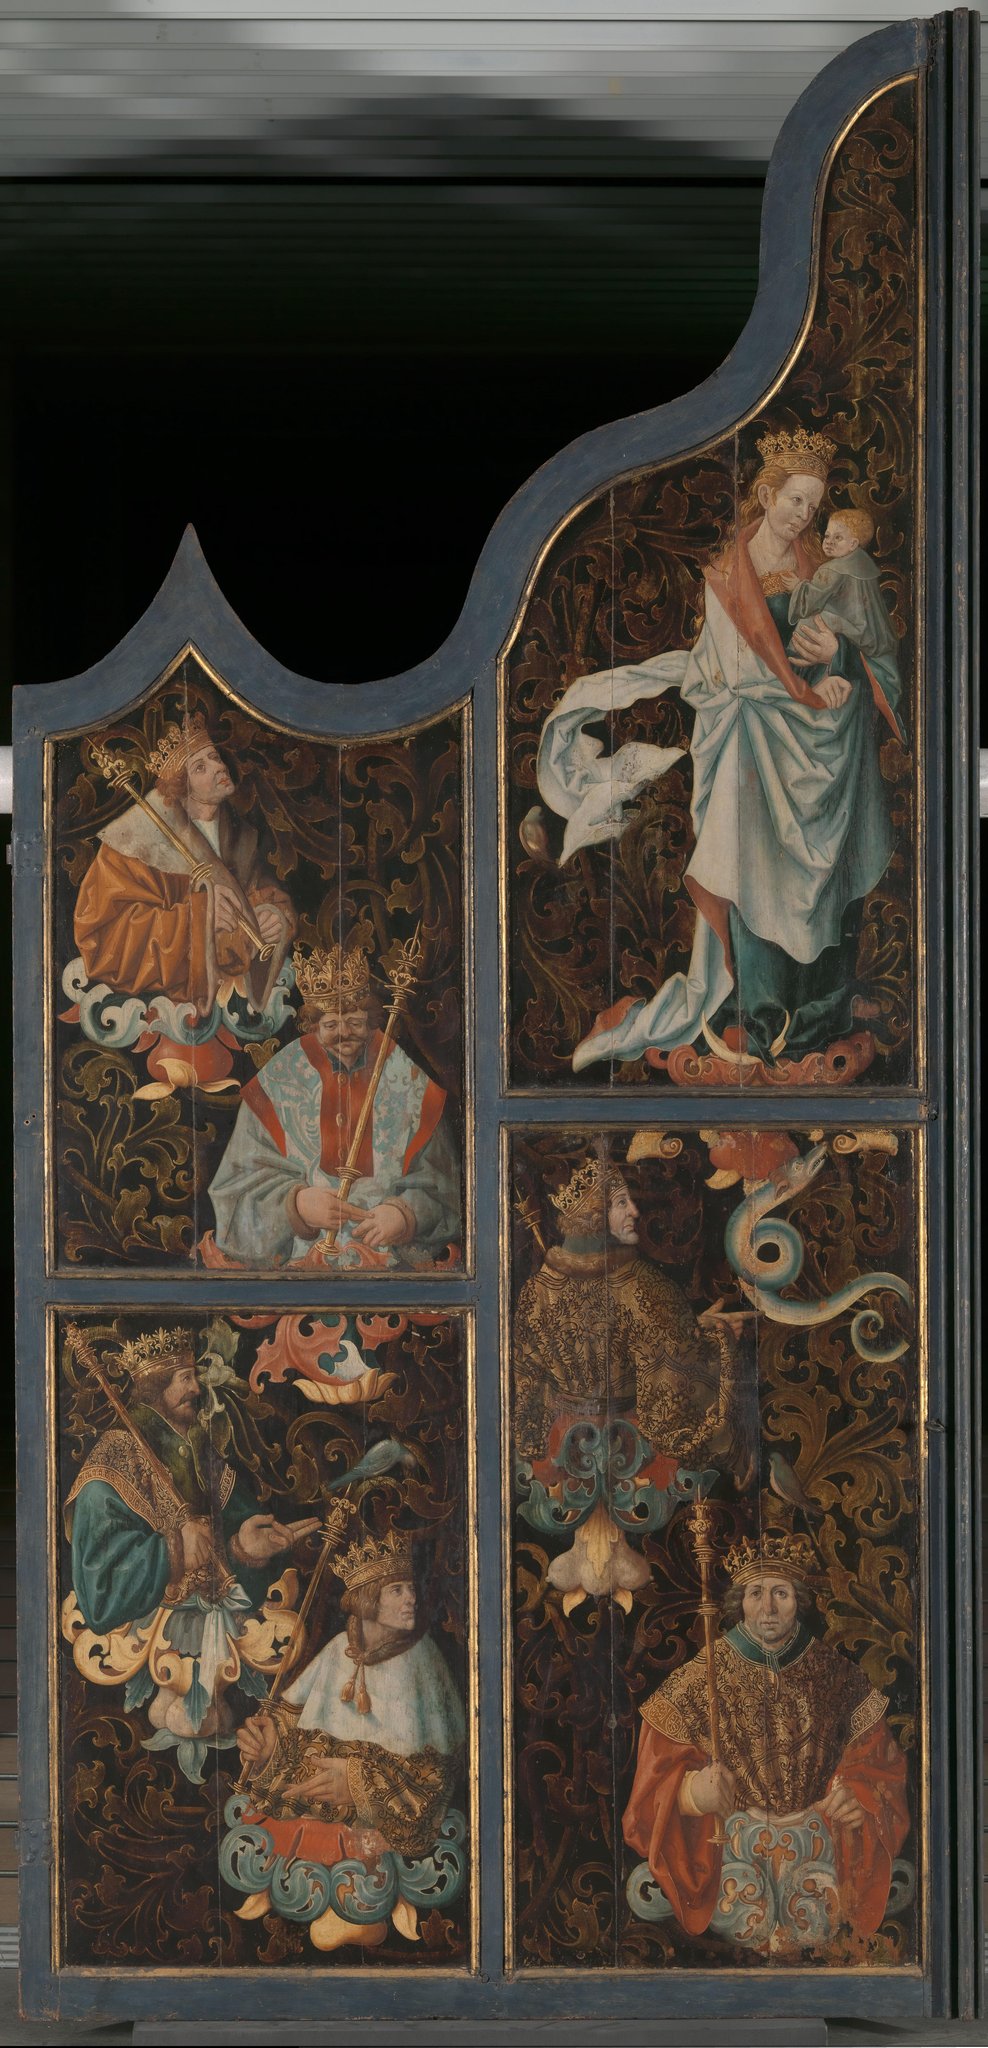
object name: organ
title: Left door of the organ from the Dutch Reformed Church in Scheemda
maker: Anonymous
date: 1526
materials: wood, oil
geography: germany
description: Linker orgelluik met op de binnenzijde De Aanbidding der Koningen. In gesloten toestand vormt dit luik samen met het rechterluik De boom van Jesse.